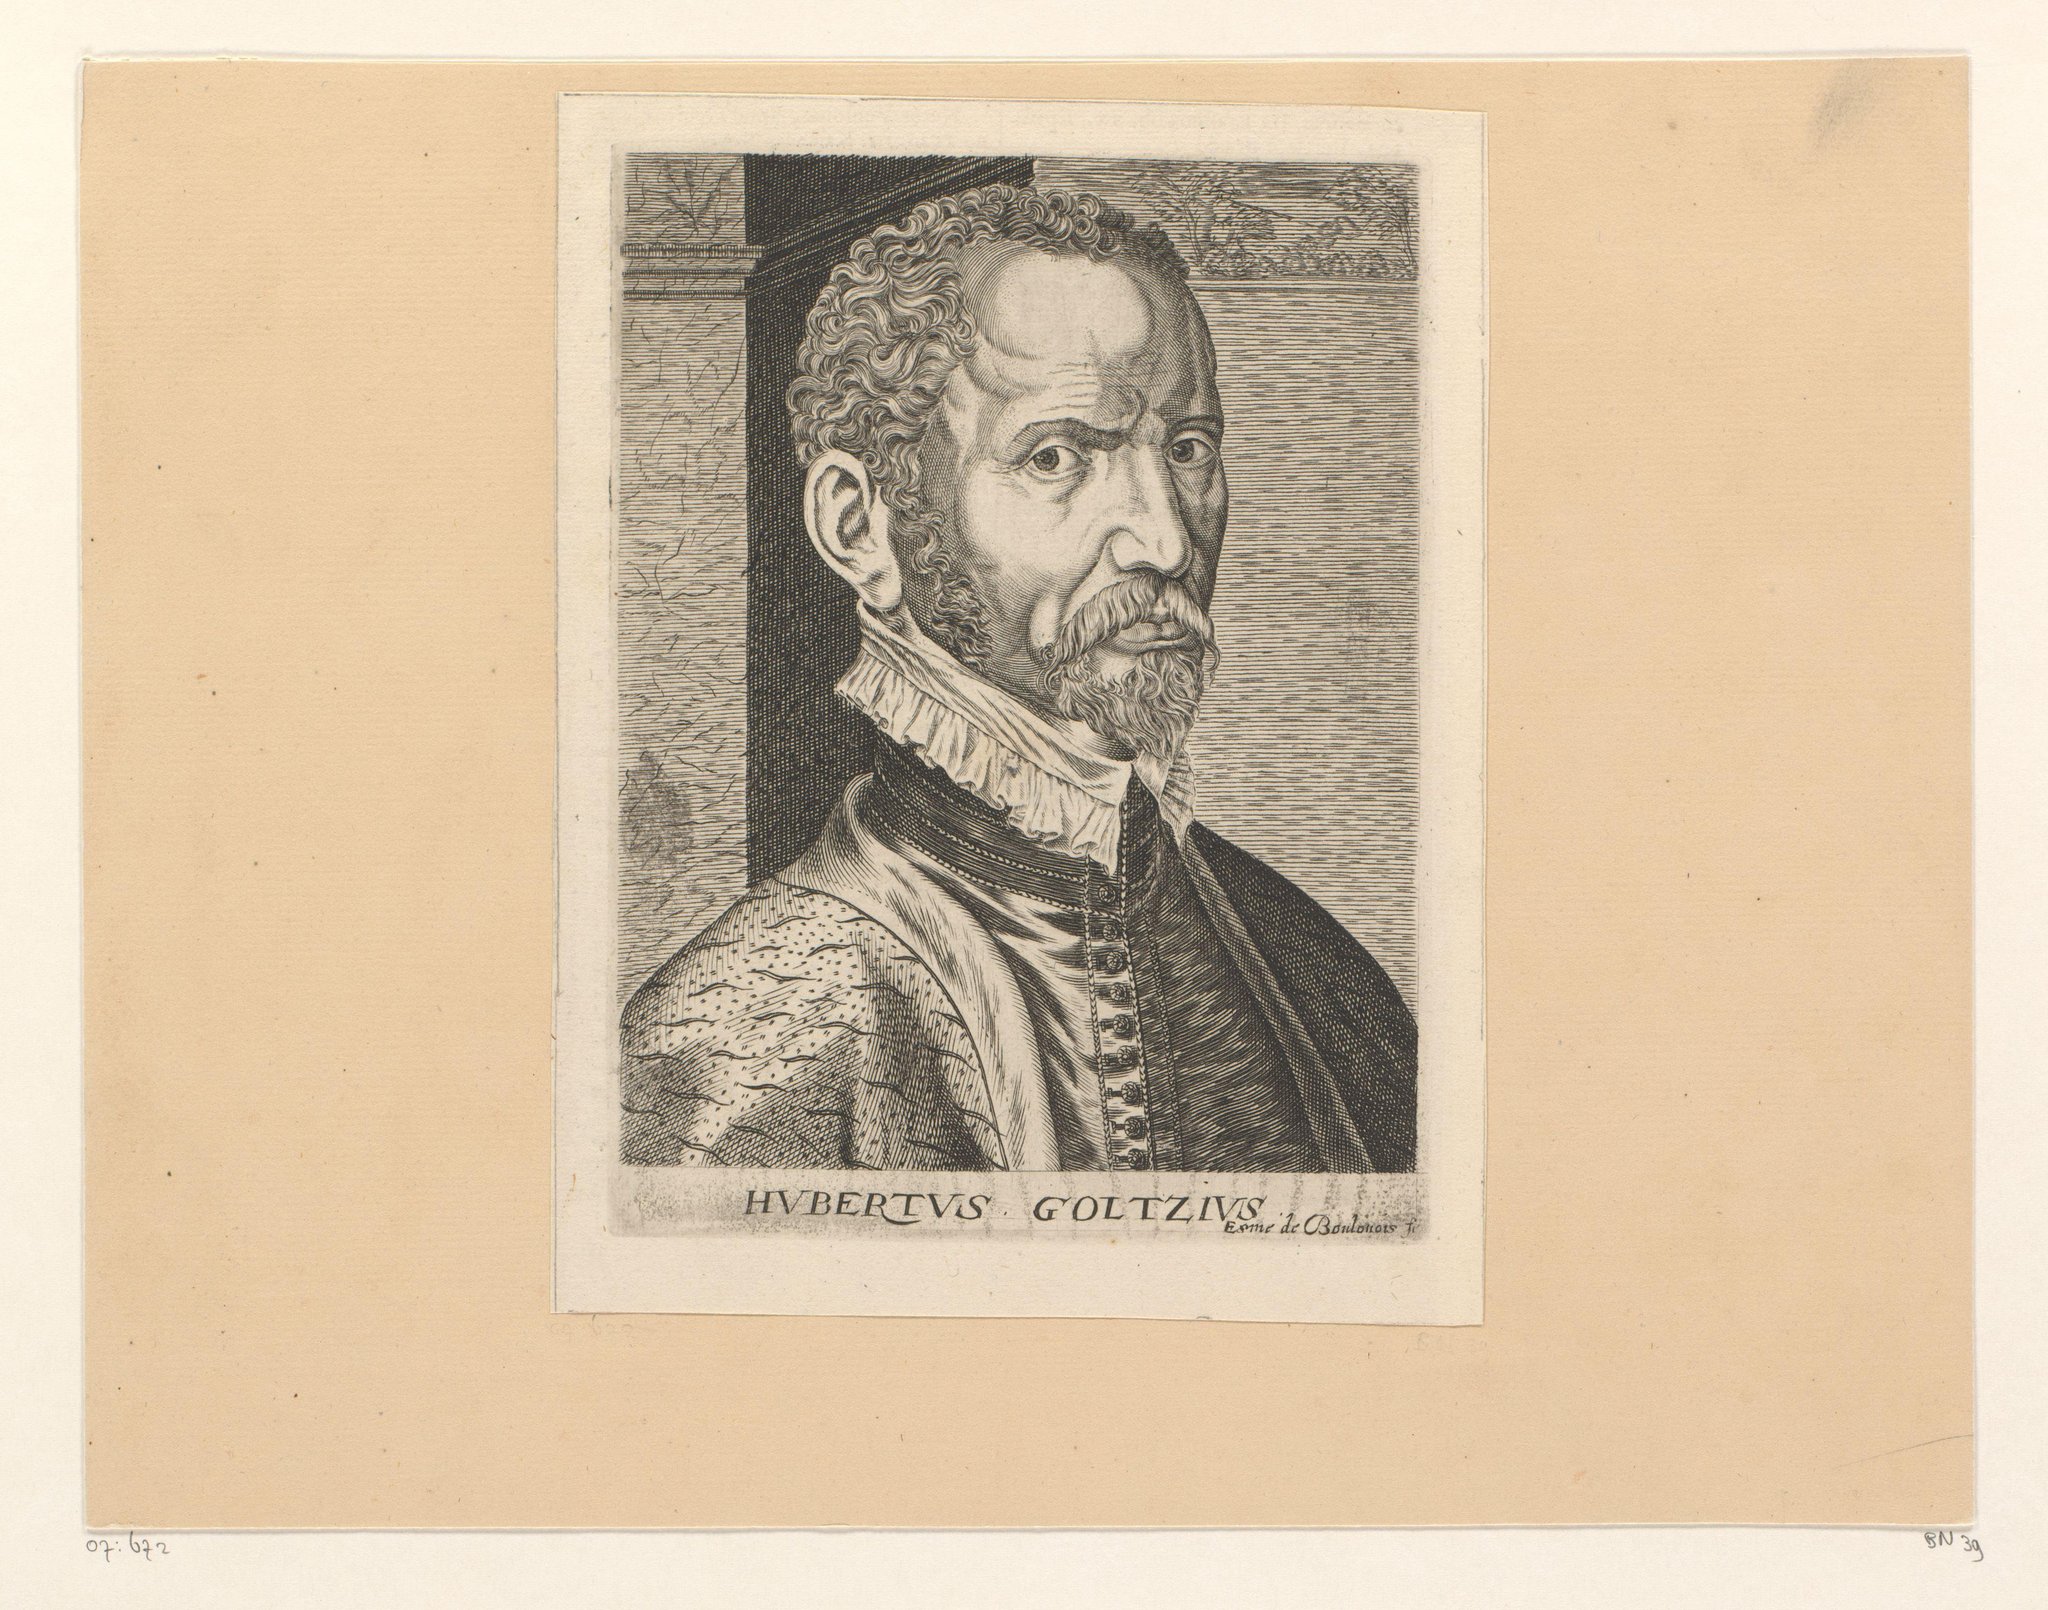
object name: print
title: Hubertus Goltzius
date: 1682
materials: paper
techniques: engraving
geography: brussels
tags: hubert goltzius, scholar, philosopher, historical persons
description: Prent uit: Bullert, Isaac. Académie des Sciences et Arts contenant les vies et éloges his. des hommes illustres qui ont excellé en ces professions depuis environ quatre siècles. Brussel: Foppens, François, 1682. Het boek werd in 1682 eveneens in Amsterdam uitgegeven door de erfgenamen van Daniel Elzevier. Deze portretten dienen ter illustratie van de biografie van een kunstenaar of geleerde. De meeste portretten werden door Nicolas de Larmessin vervaardigd (162), 93 door De Boulonois en een derde door ongeïdentificeerde prentmakers. Dit betreft een illustratie op p. 161, deel I.